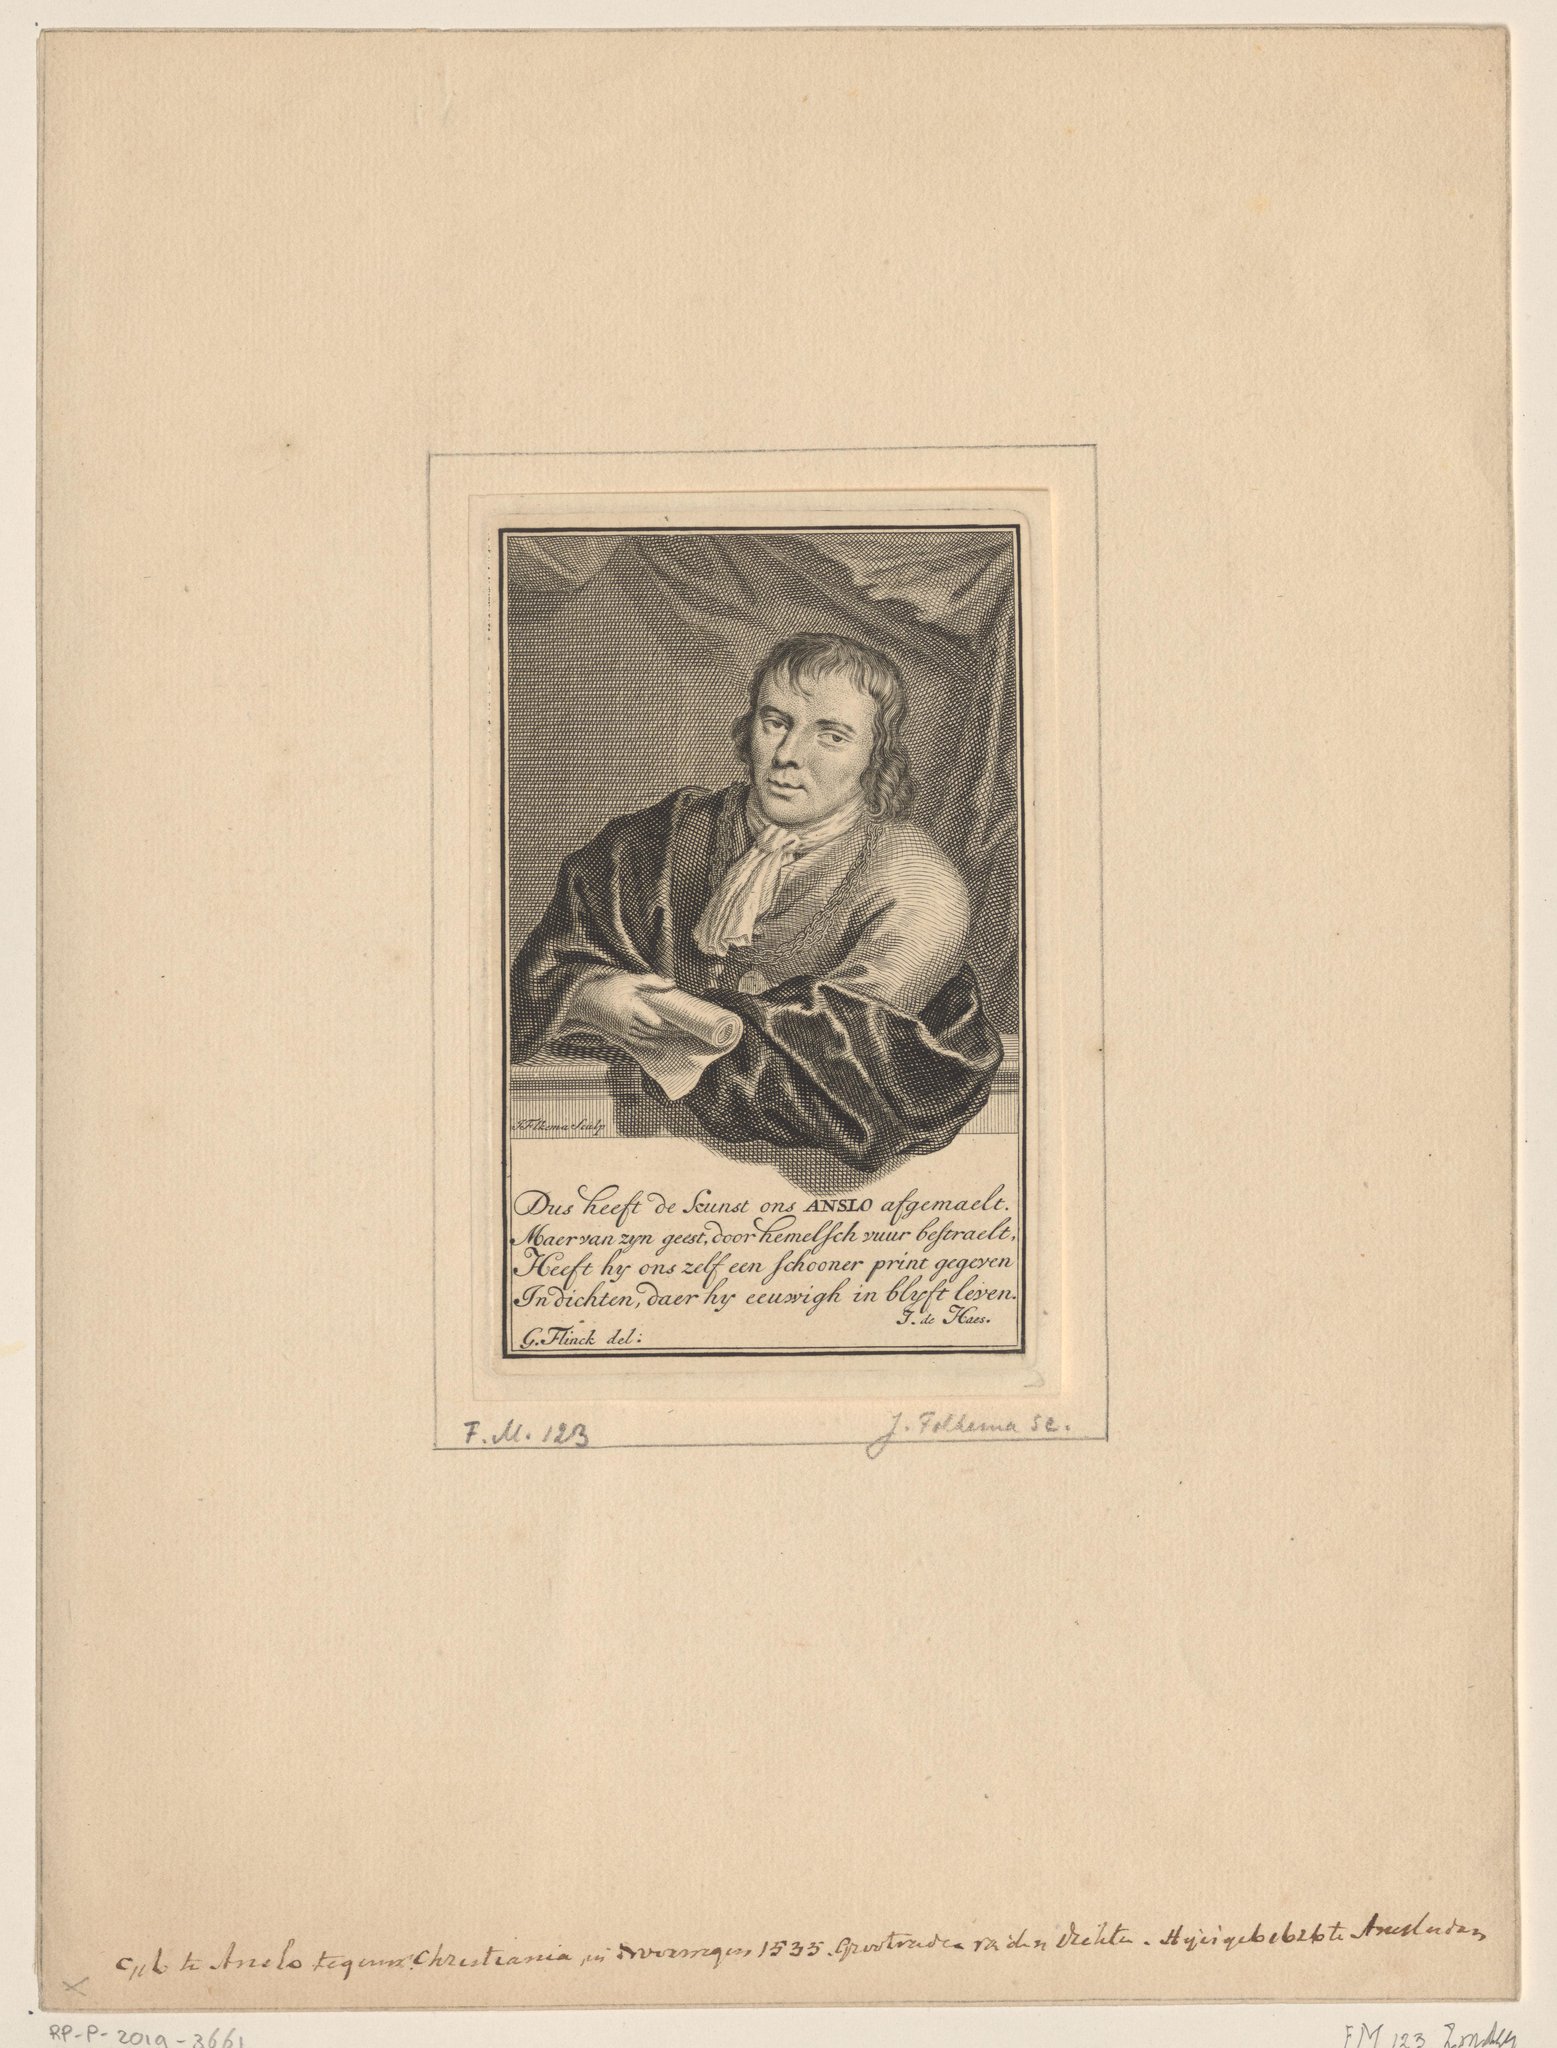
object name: print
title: Portret van Reyer Anslo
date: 1713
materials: paper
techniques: engraving, etching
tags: reyer anslo, historical persons, writer, poet, author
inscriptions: collector's mark: Lugt 2228, inscription: ‘[...]’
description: Prent met tekst in boekdruk op verso verschenen in: Anslo, Reyer en Joan de Haes. R. Ansloos poezy. Rotterdam: Barent Bos, 1713.